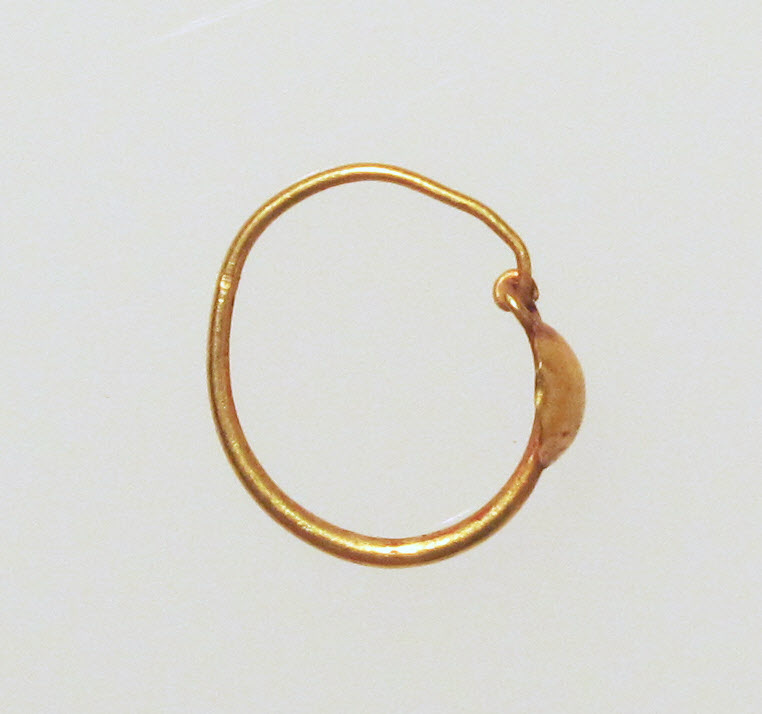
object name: earring with plain loop and disc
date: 7000 BCE-330 CE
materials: gold